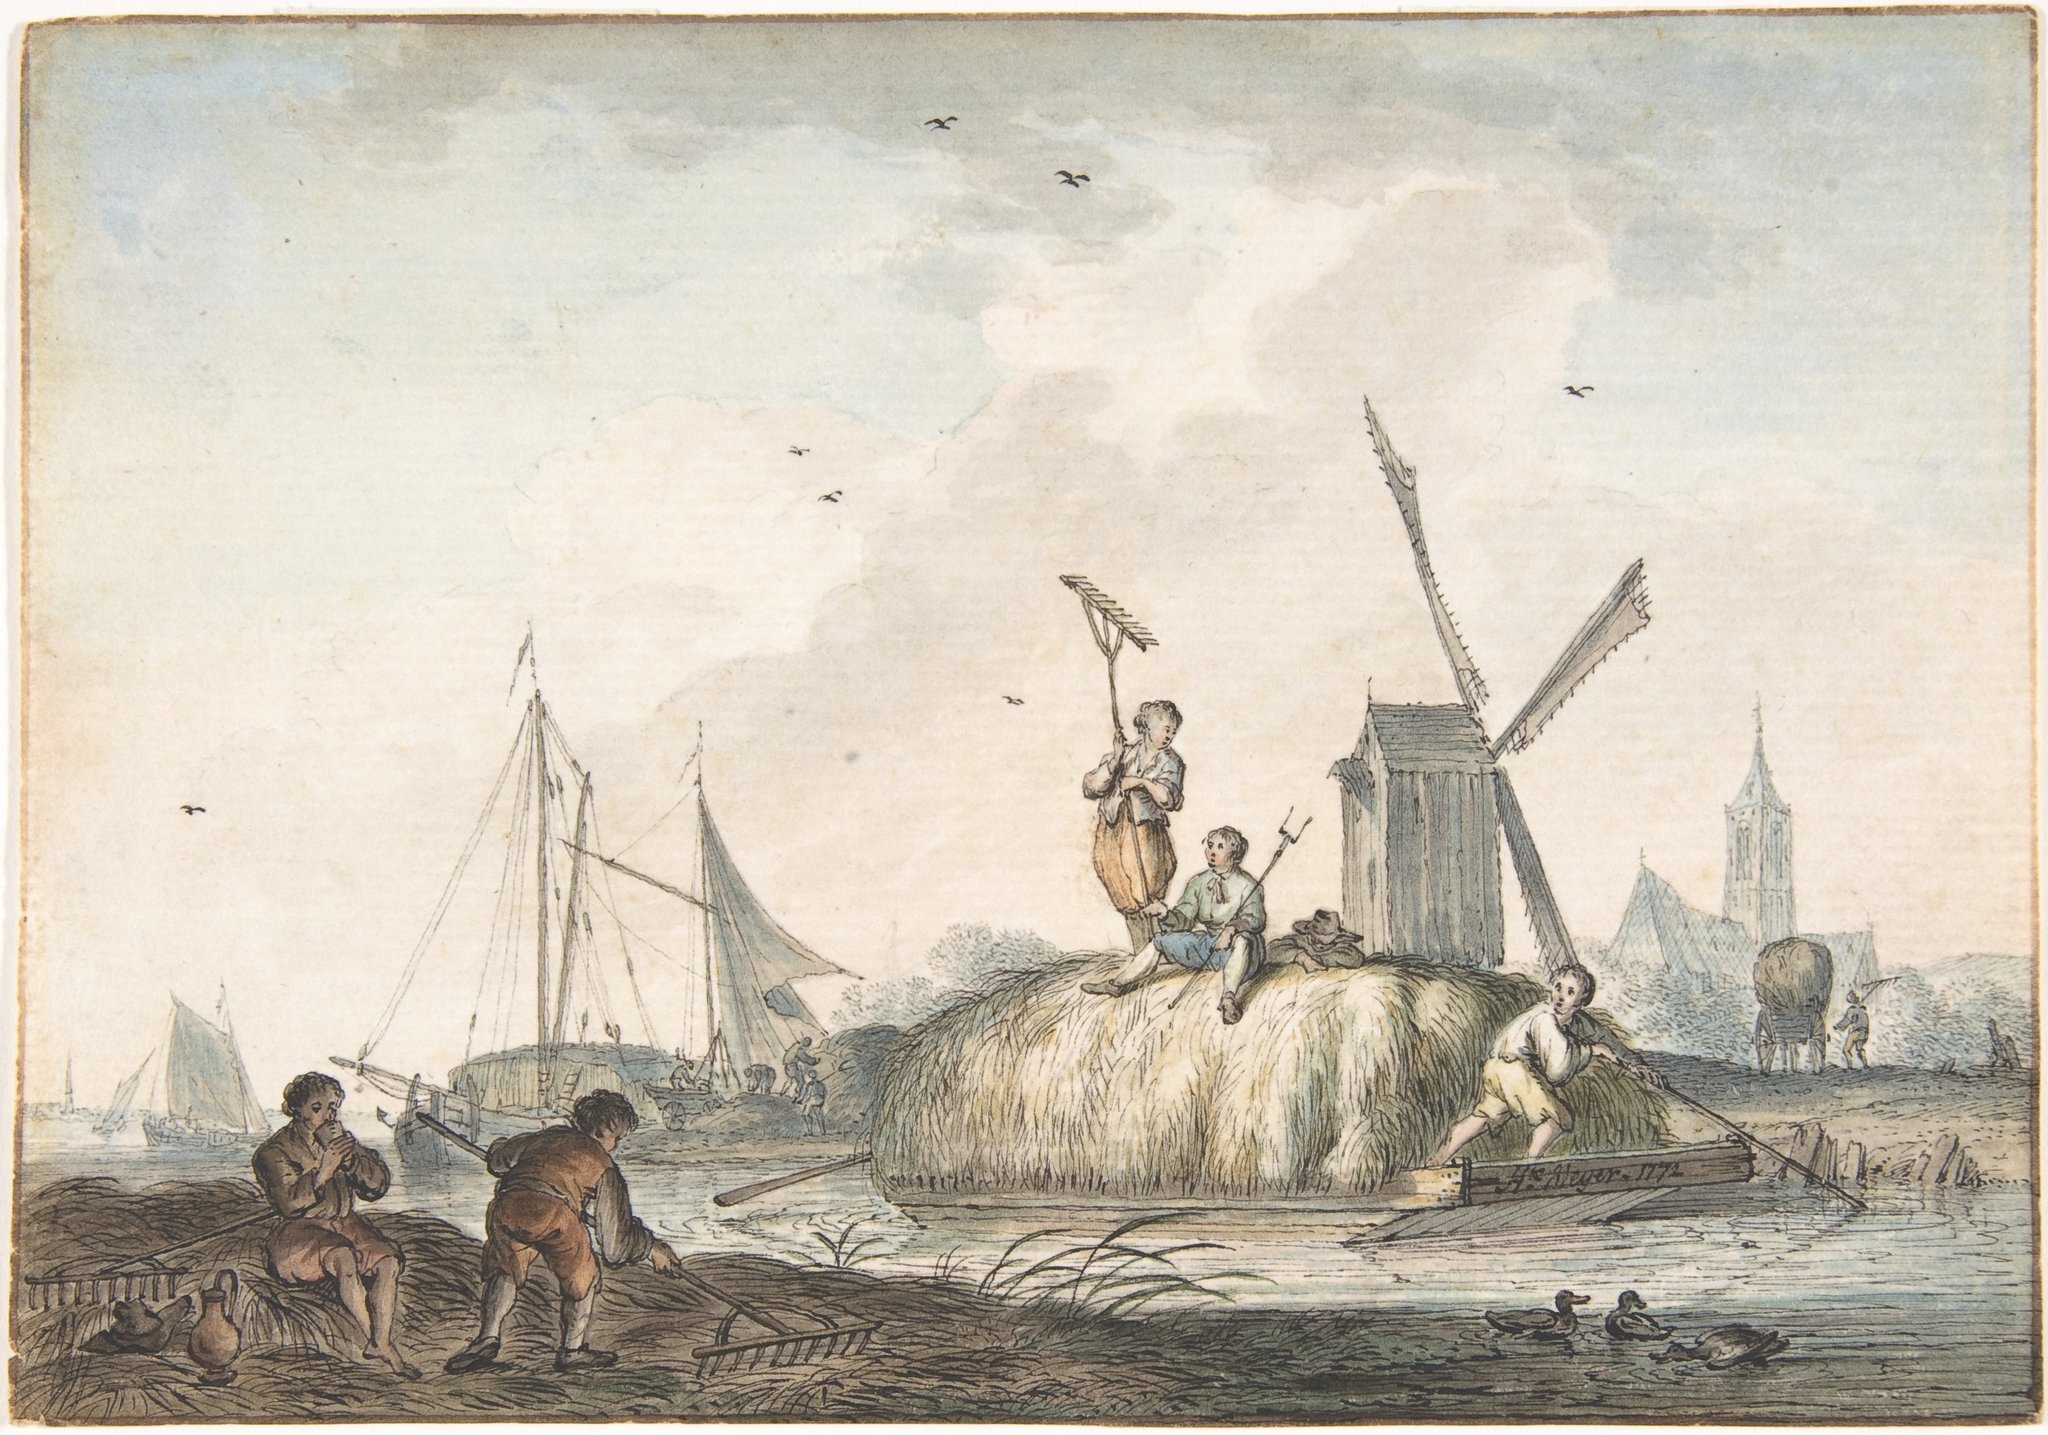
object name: drawing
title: The Twelve Months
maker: hendrik meijer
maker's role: artist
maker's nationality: dutch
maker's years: 1744-1793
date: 1772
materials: chalk, ink, watercolor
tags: ducks,windmills,boys,men,boats